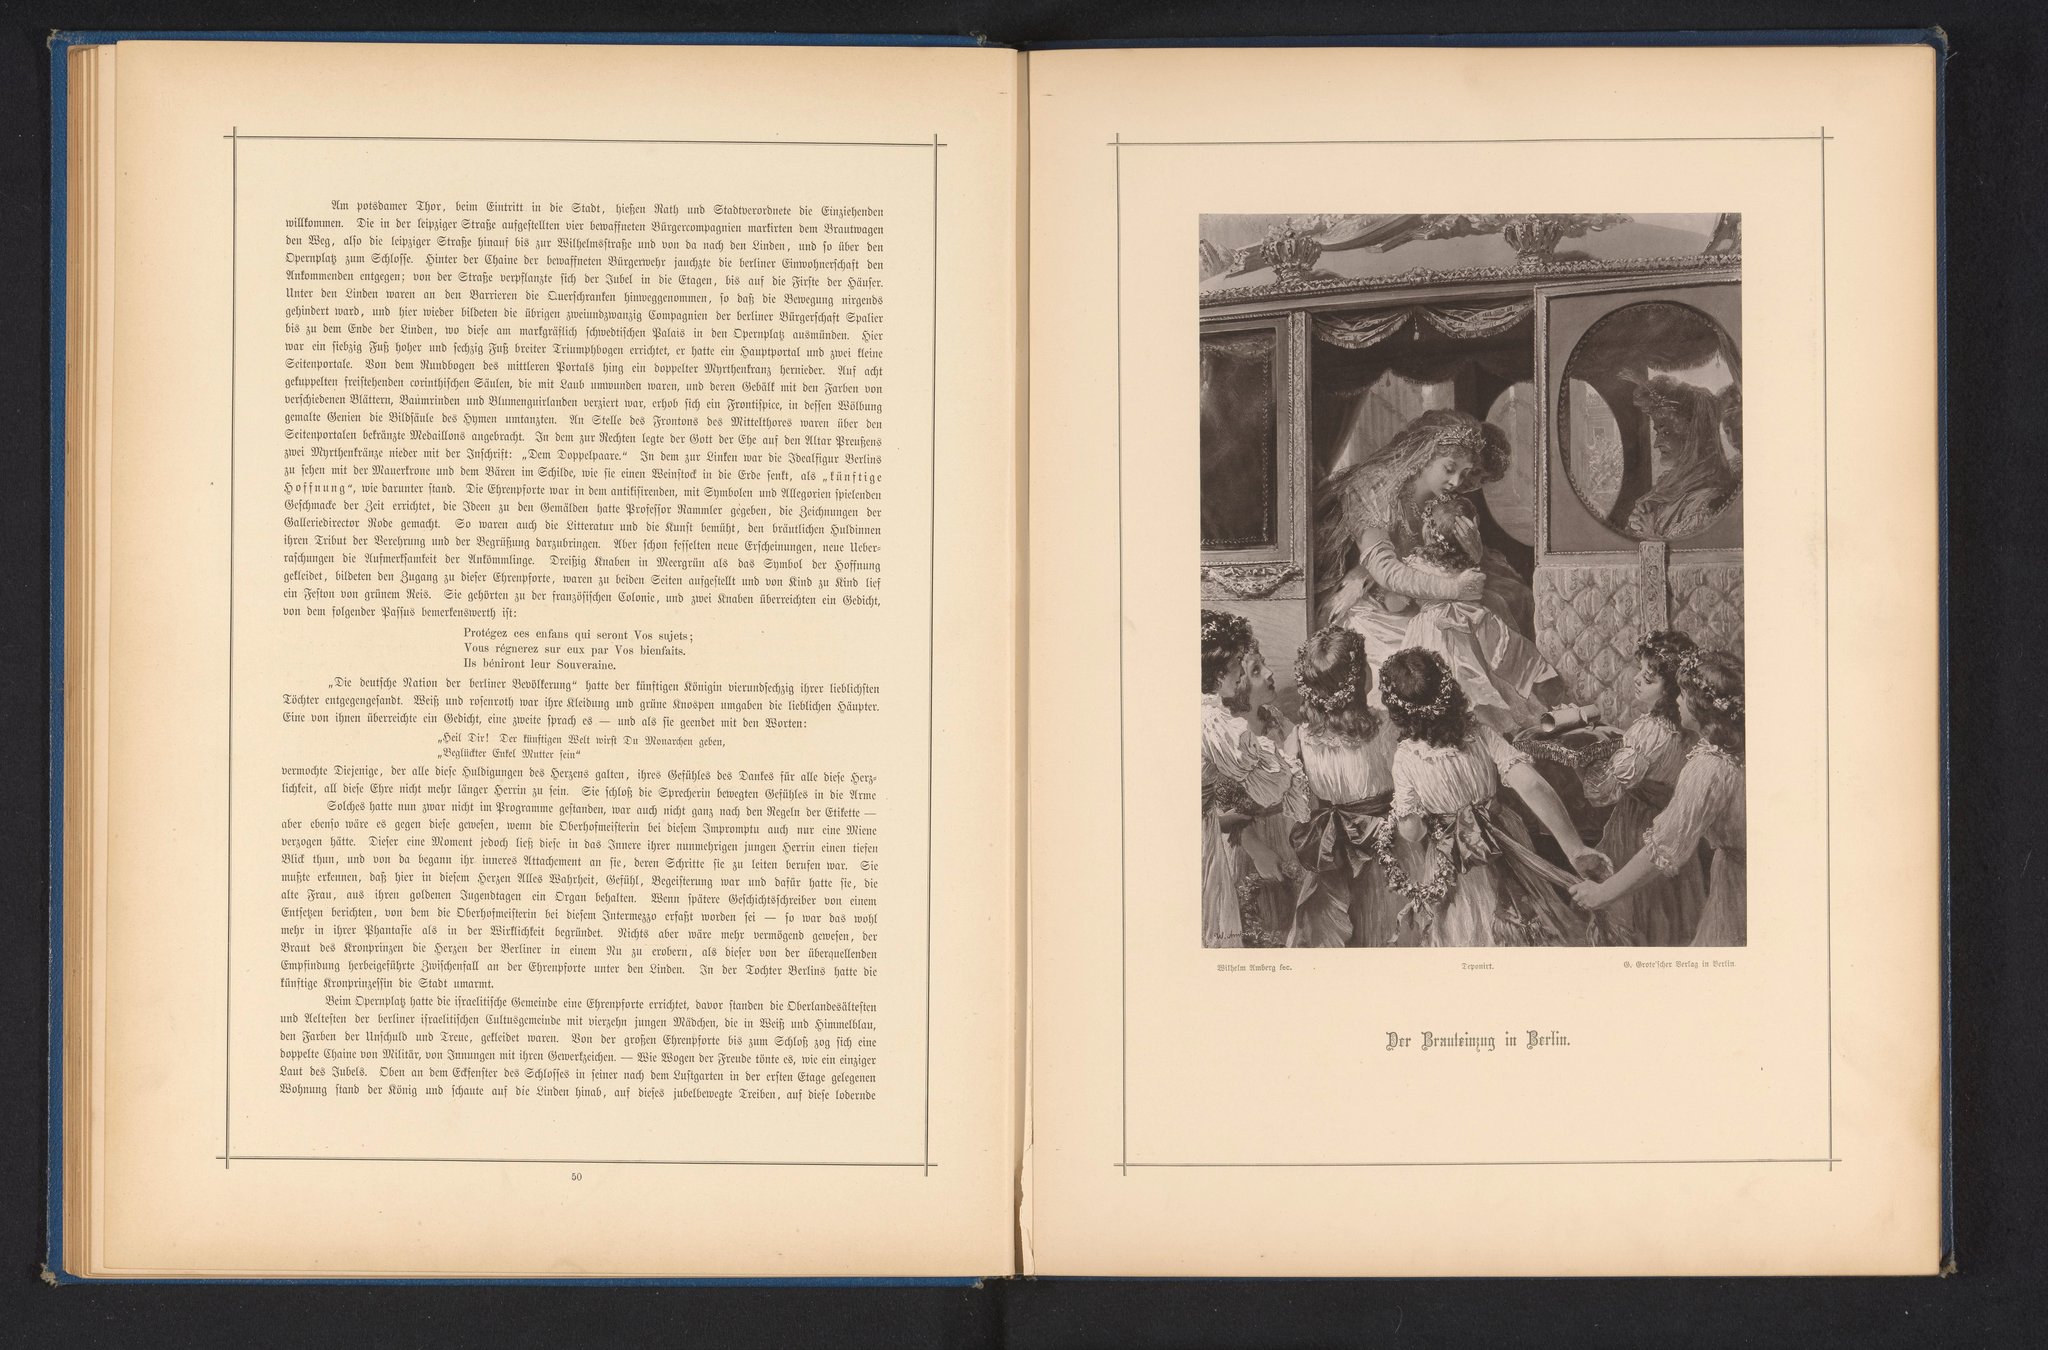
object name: photomechanical print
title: Der Brauteinzug in Berlin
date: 1873-1883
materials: paper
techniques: photograph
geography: berlin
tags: bus, coach, bride (in wedding-dress)